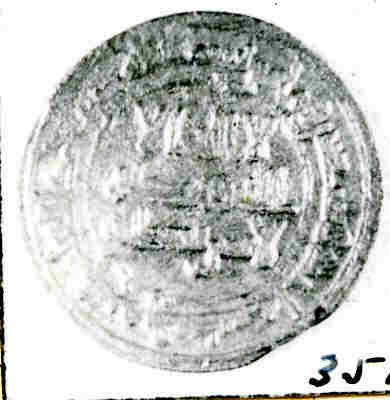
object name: coin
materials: copper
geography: uzbekistan